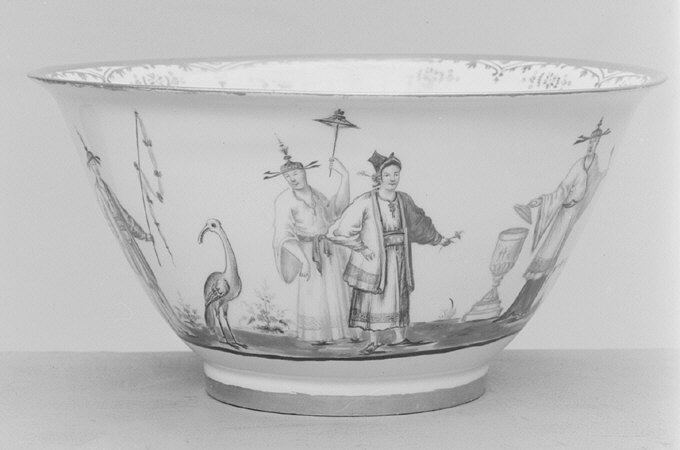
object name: bowl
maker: meissen manufactory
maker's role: manufactory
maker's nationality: german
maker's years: 1710-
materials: hard paste porcelain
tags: birds,chinoiserie,men,women